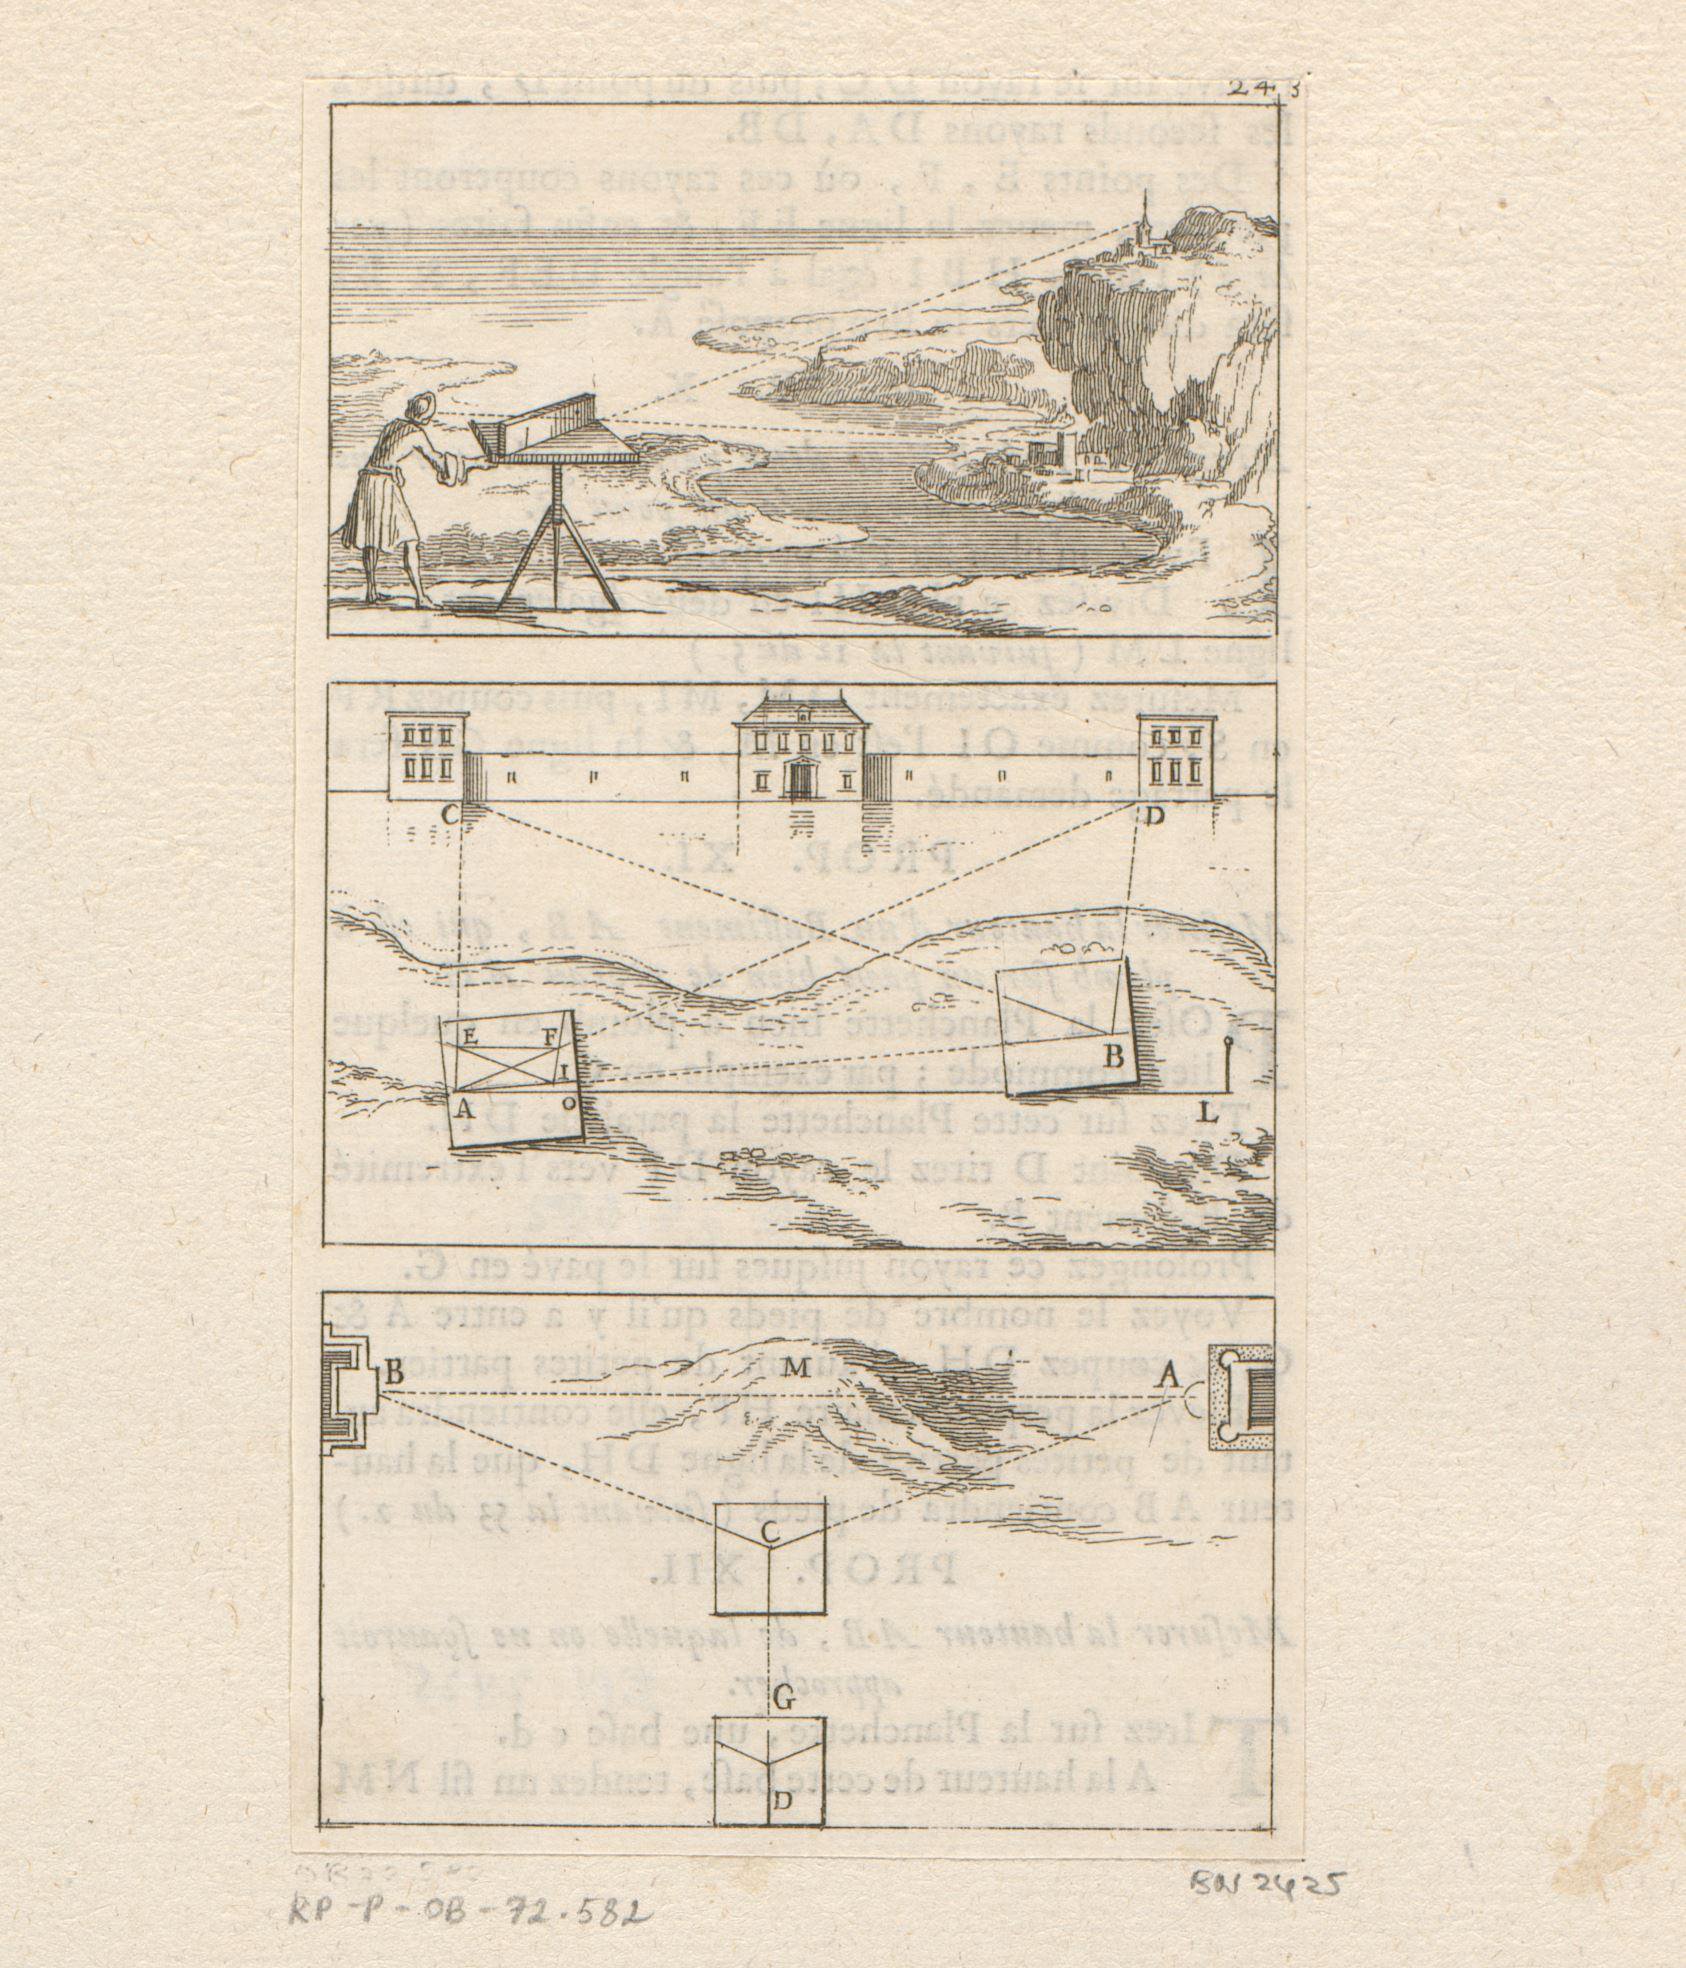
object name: print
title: Gebruik van de meetplank op drie manieren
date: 1690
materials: paper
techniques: etching, letterpress printing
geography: france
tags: planimetry, geometry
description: Prent uit: Leclerc, Sébastien. Traité de géométrie (...). Parijs: Jean Jombert, 1690.